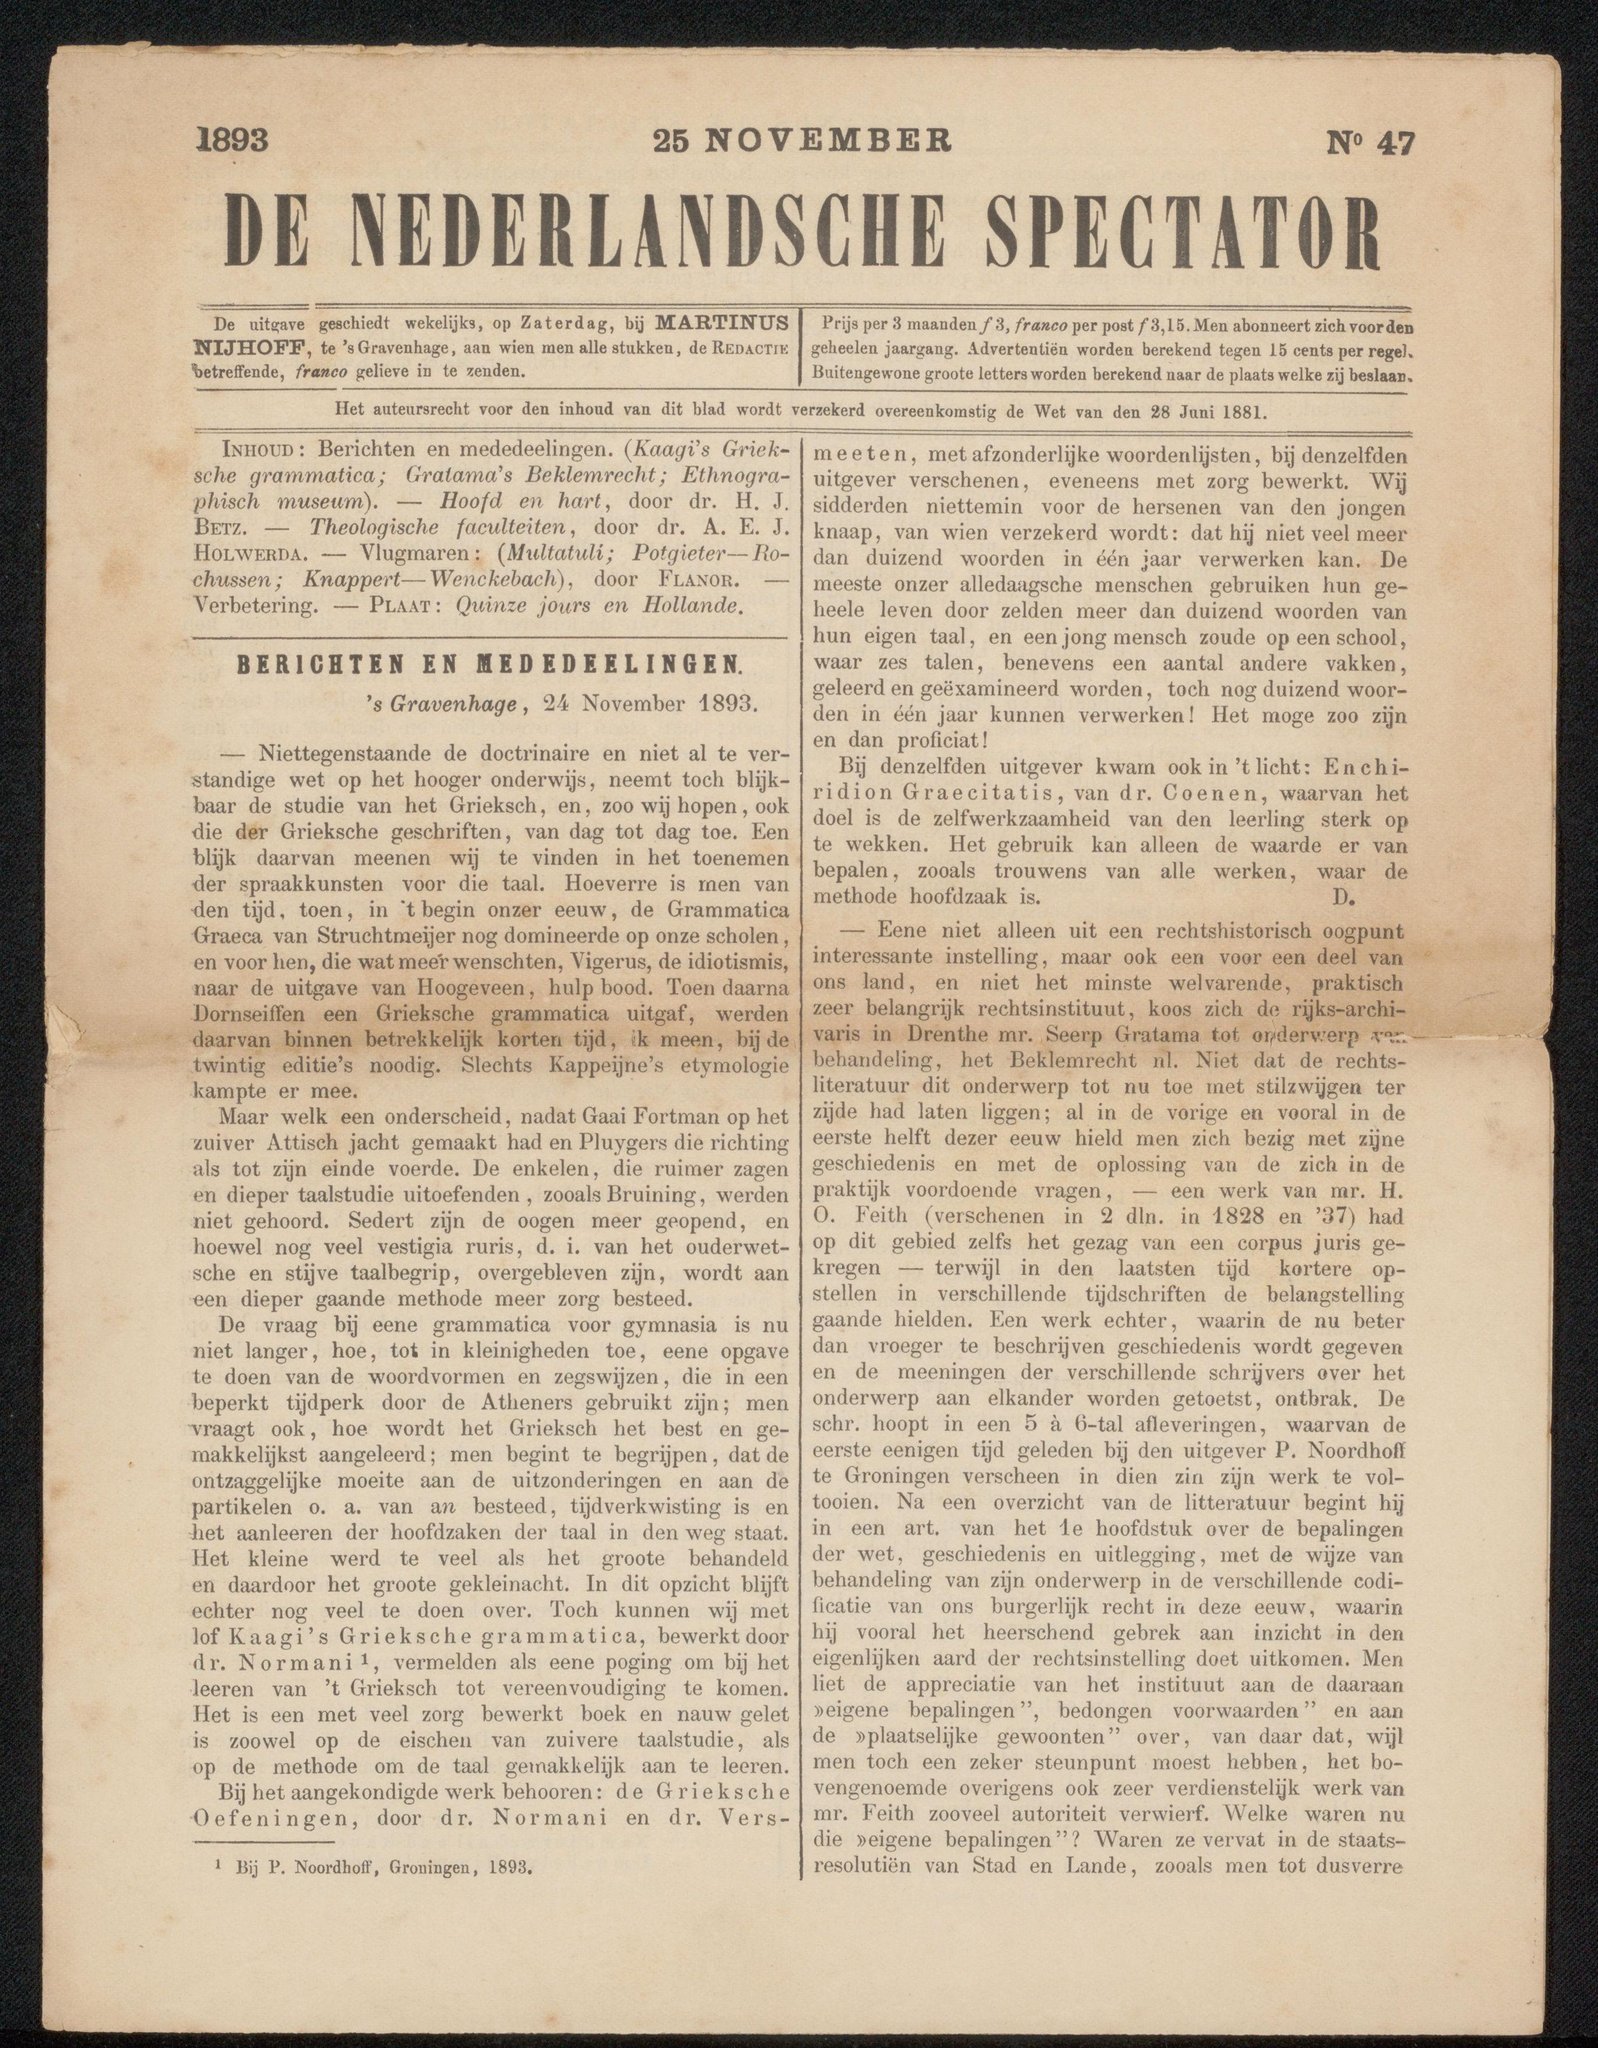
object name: magazine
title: Tijdschrift uit archief Philip Zilcken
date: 1893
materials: paper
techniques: printing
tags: paris, paul verlaine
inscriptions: collector's mark: ‘RPK’